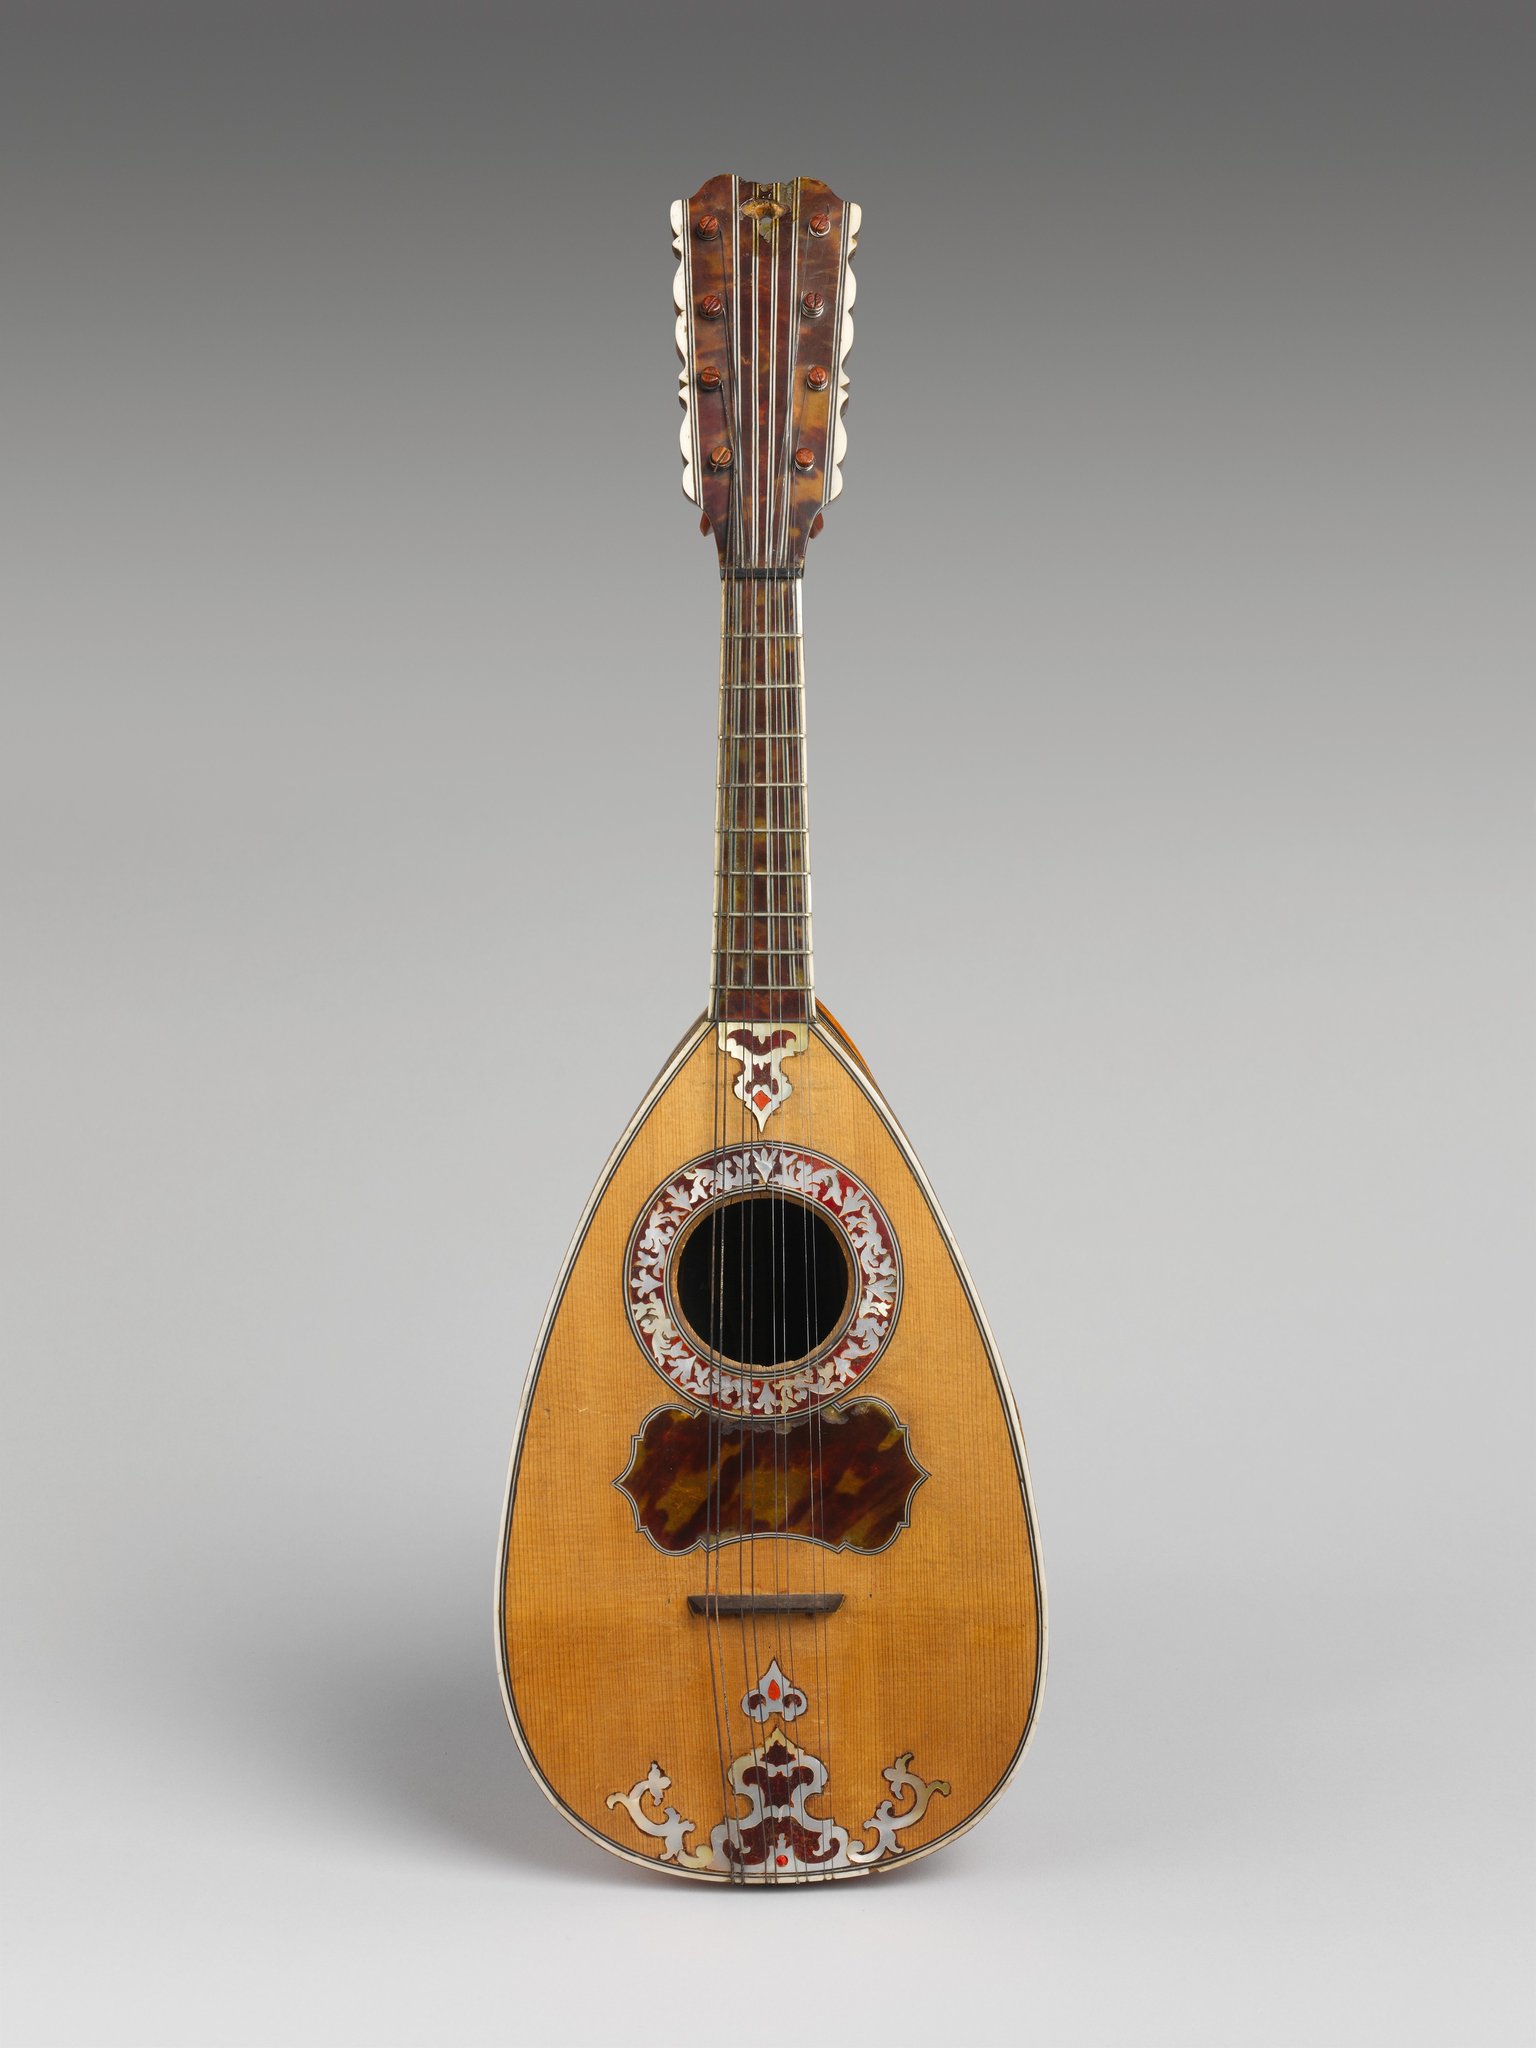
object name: mandolin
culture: italian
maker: vincentius vinaccia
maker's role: maker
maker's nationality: italian, naples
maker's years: 1769-1795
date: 1770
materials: ivory, wood, mother of pearl, shell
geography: italy